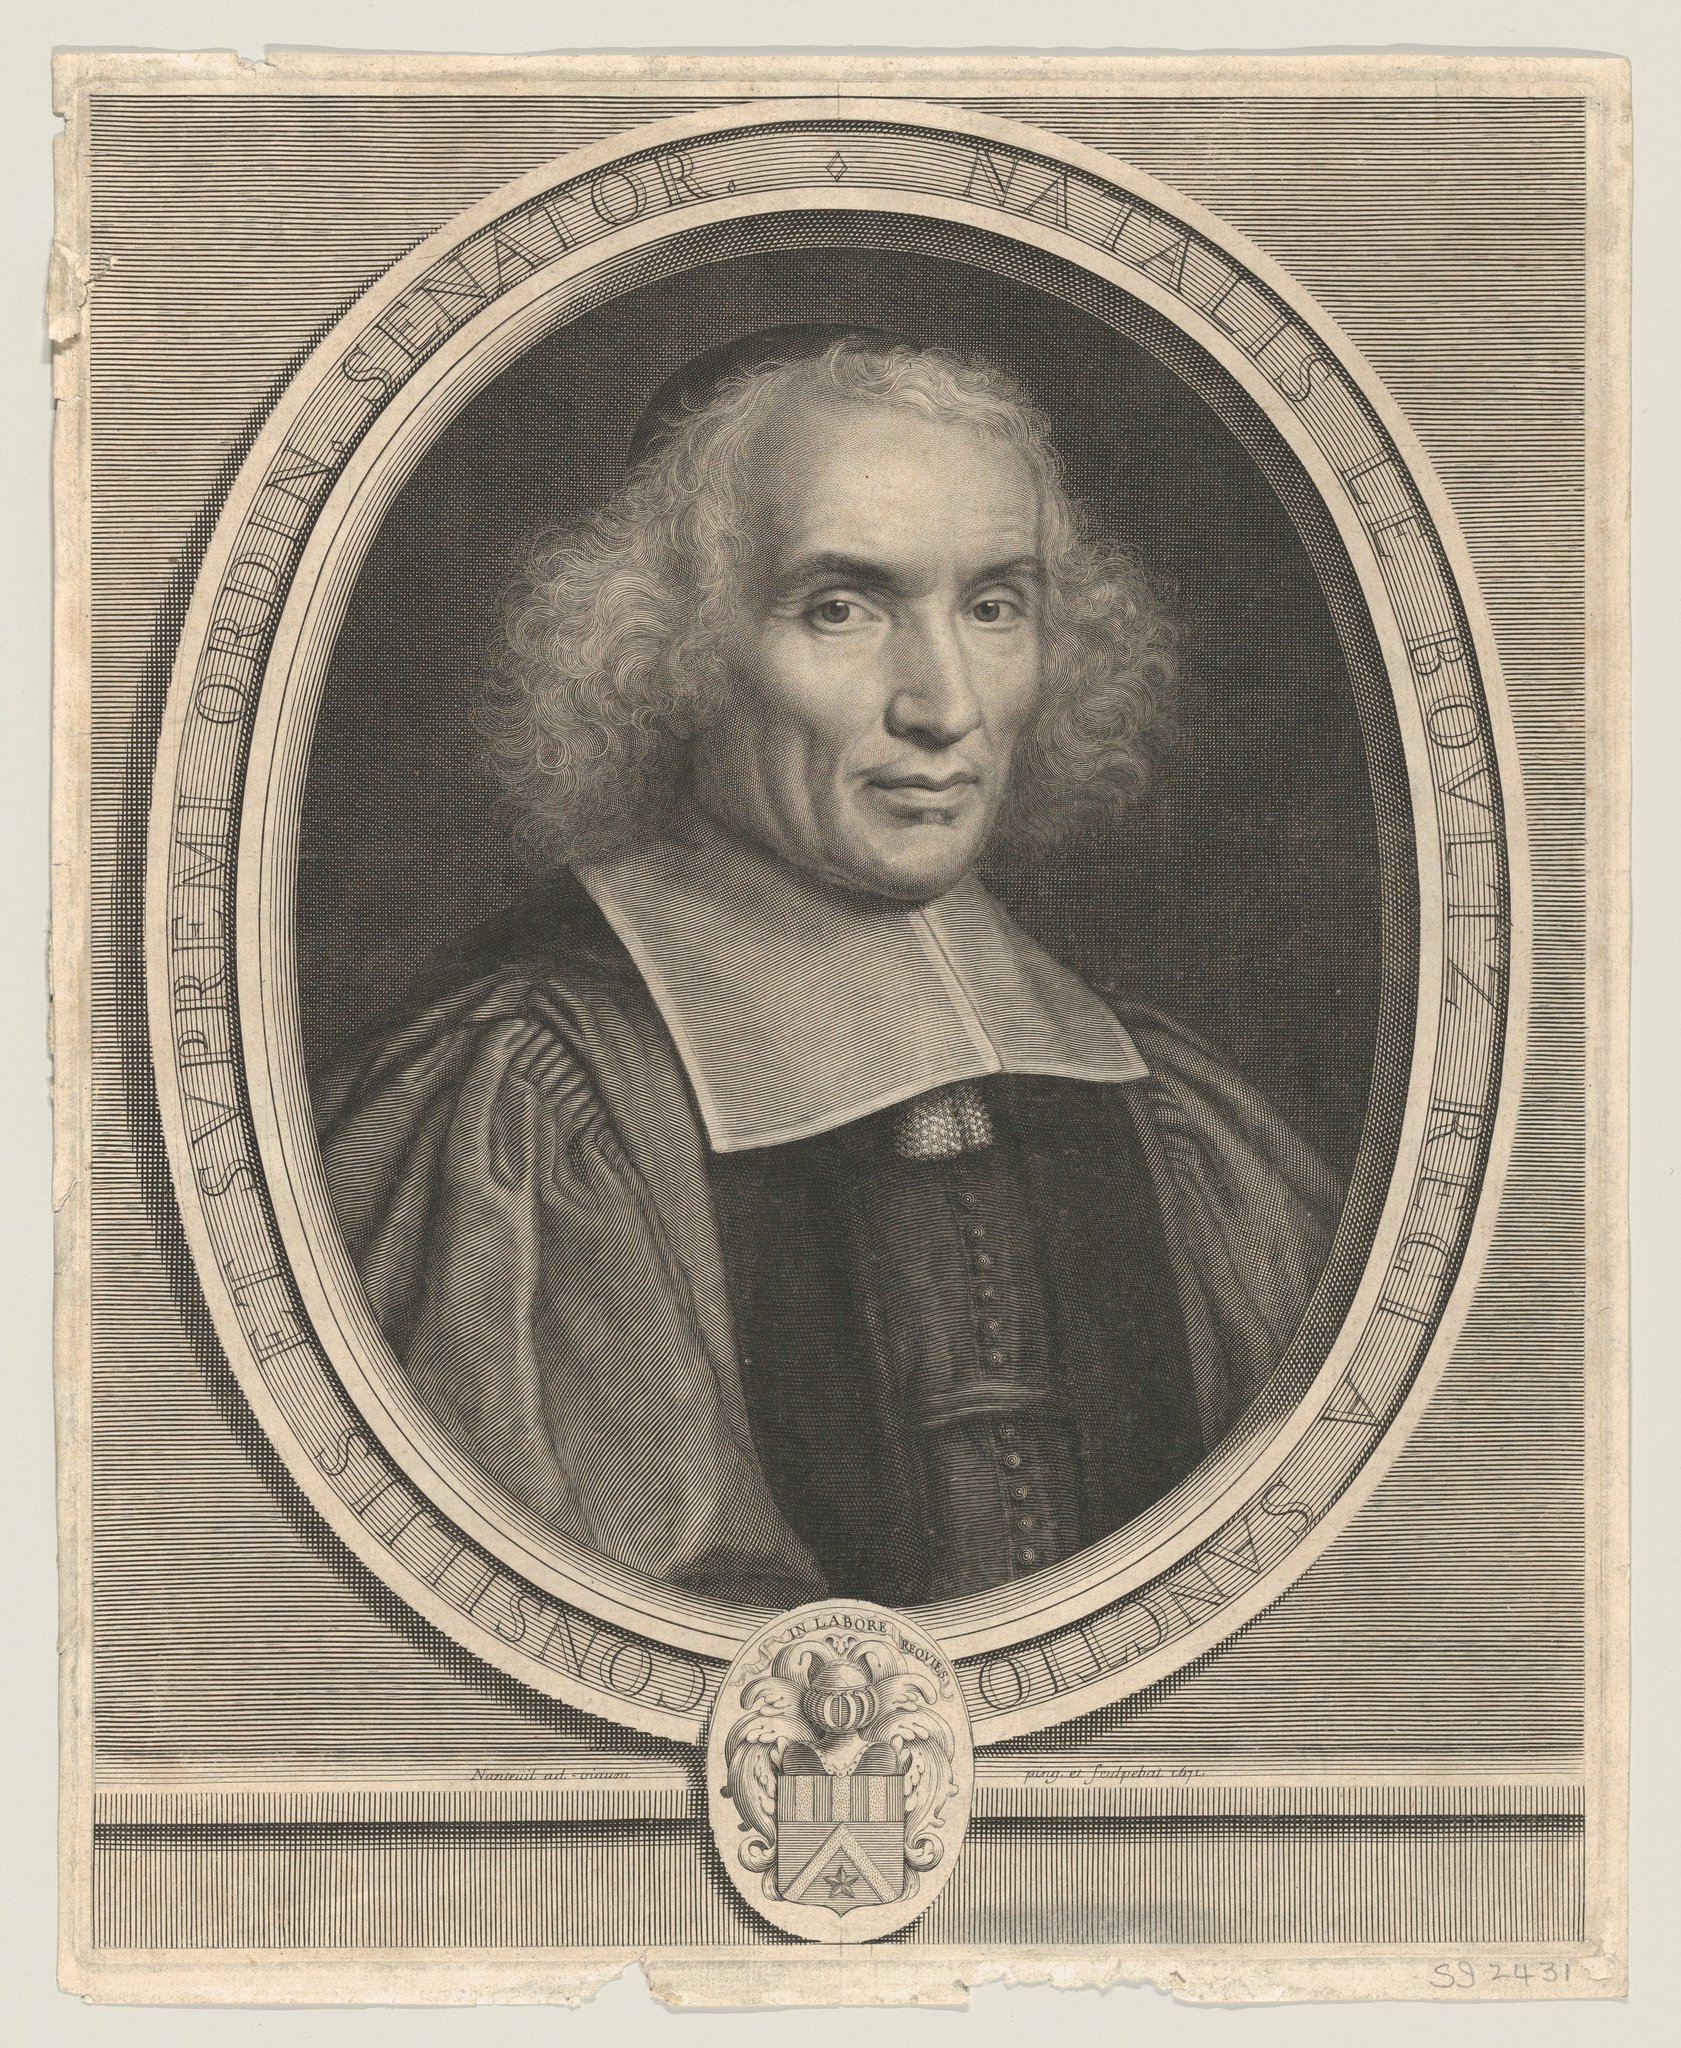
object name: print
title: Portrait of the French Magistrate Noël Le Boultz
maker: robert nanteuil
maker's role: artist and engraver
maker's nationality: french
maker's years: 1623-1678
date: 1671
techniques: engraving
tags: men,portraits,coat of arms